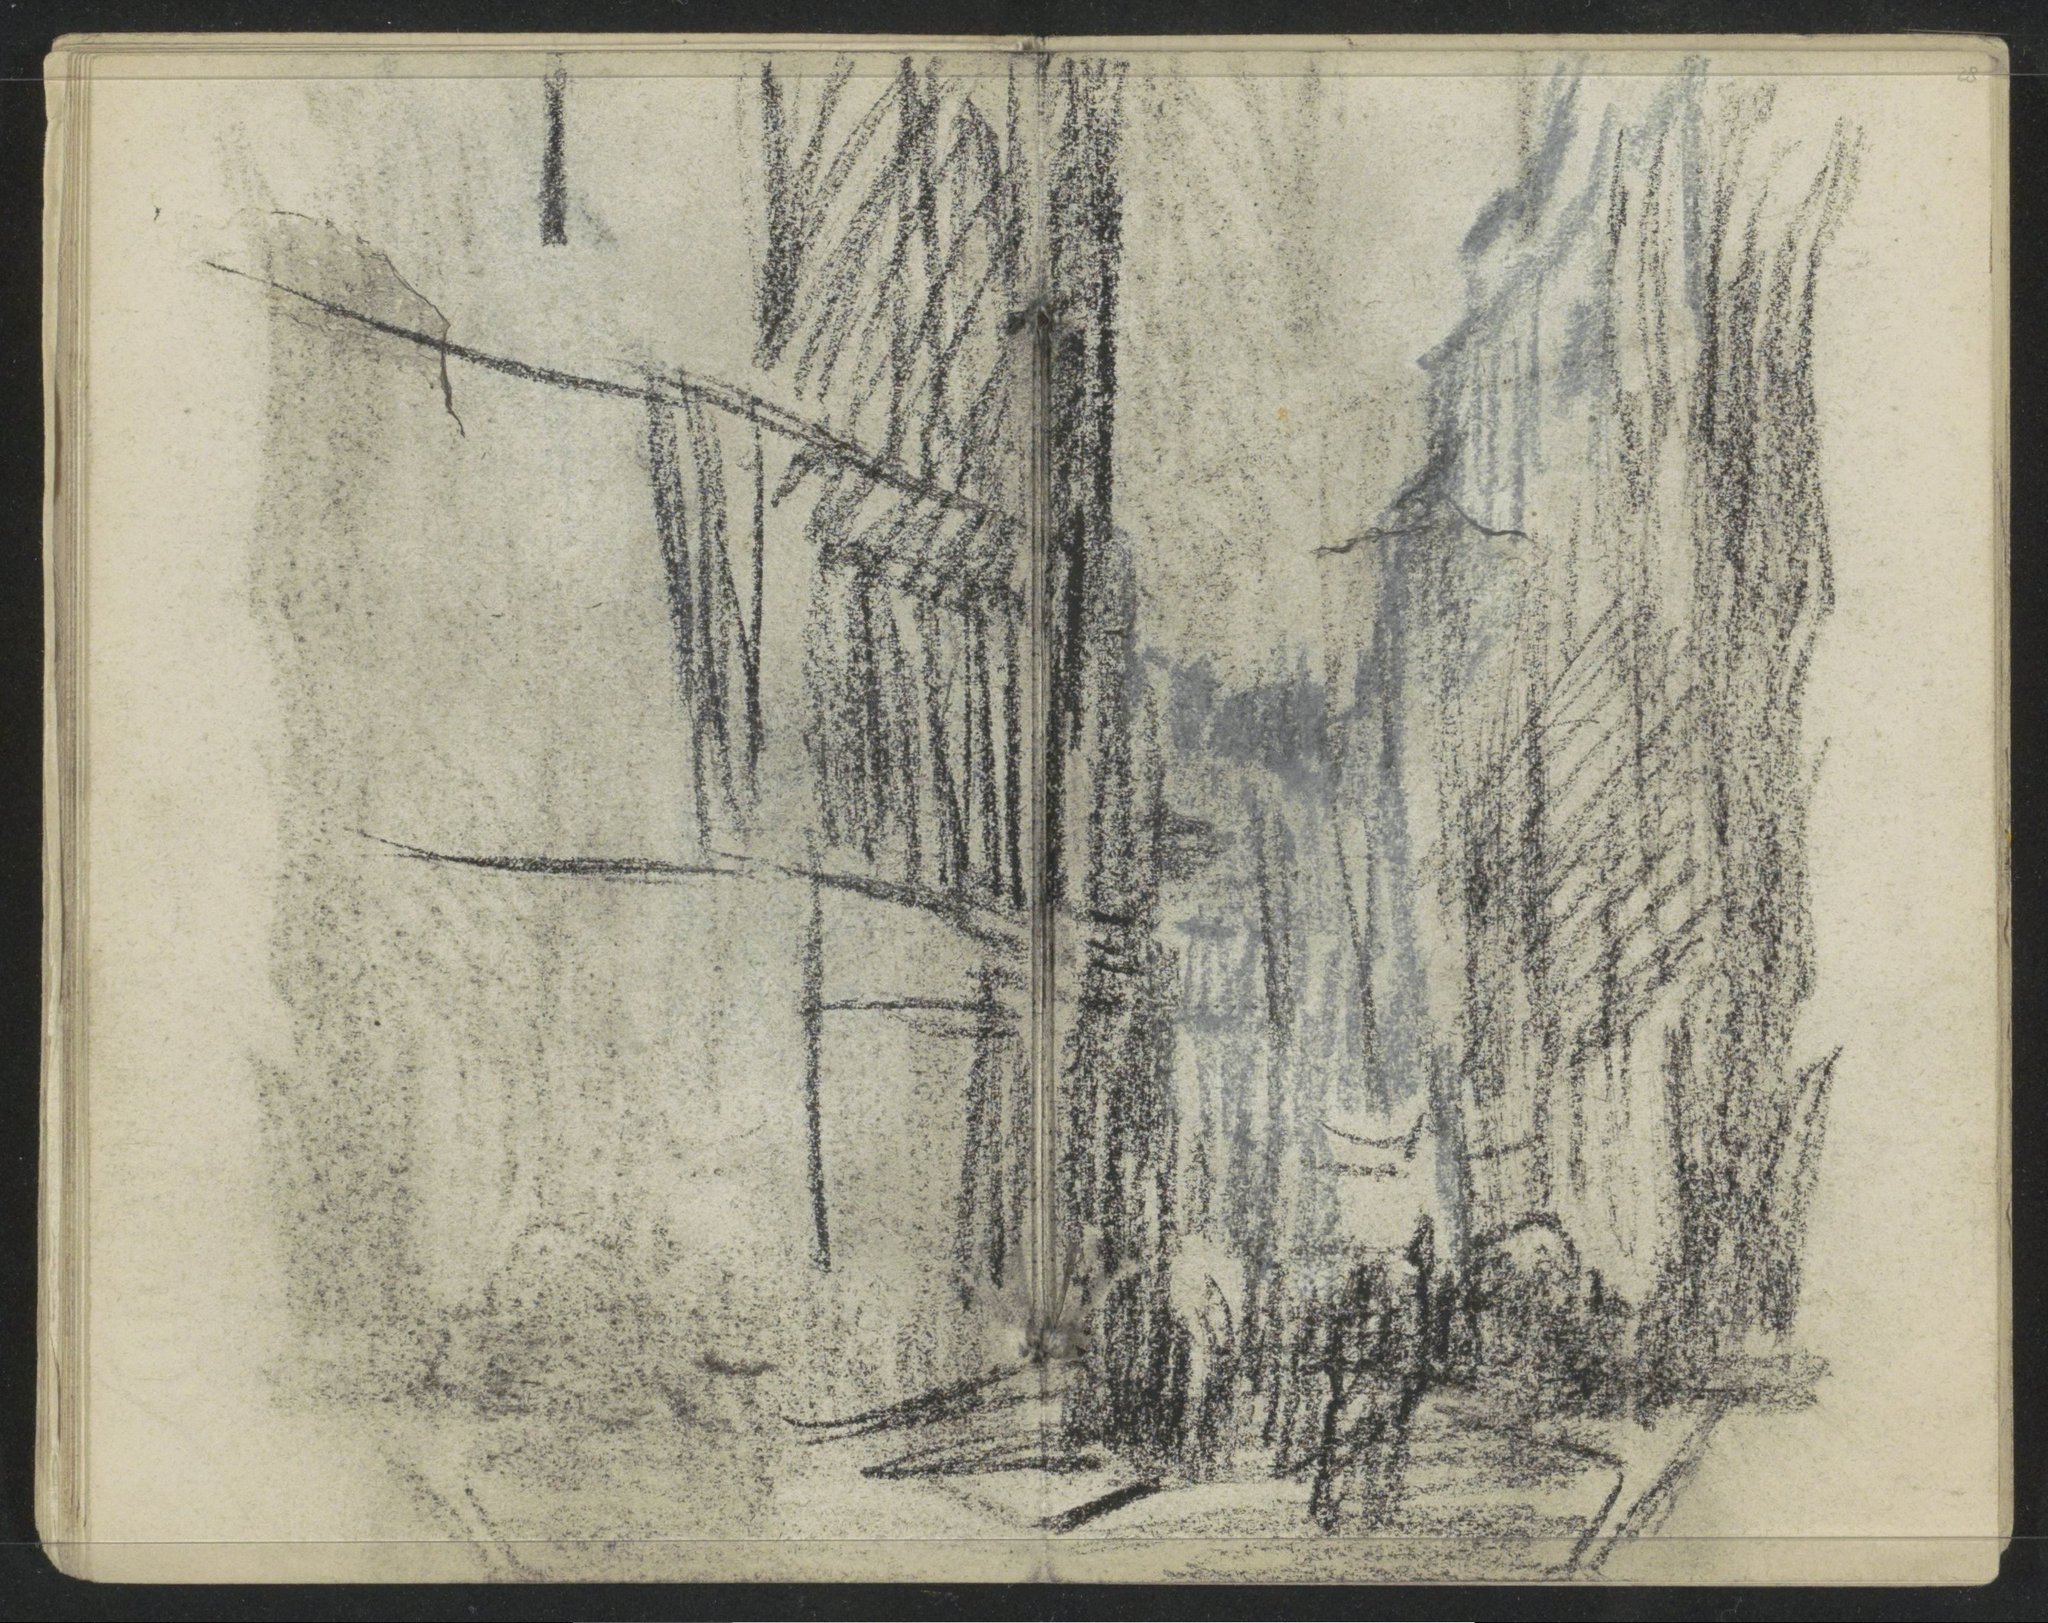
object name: sketchbook leaf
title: Figuren op straat, mogelijk in Parijs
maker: isaac israels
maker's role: draughtsman, painter, print maker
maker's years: 1865-1934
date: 1887-1934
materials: chalk, paper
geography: paris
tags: street (+ city(-scape) with figures, staffage), paris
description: Pagina 27 en pagina 28 uit schetsboek XXXIX met 51 pagina's.